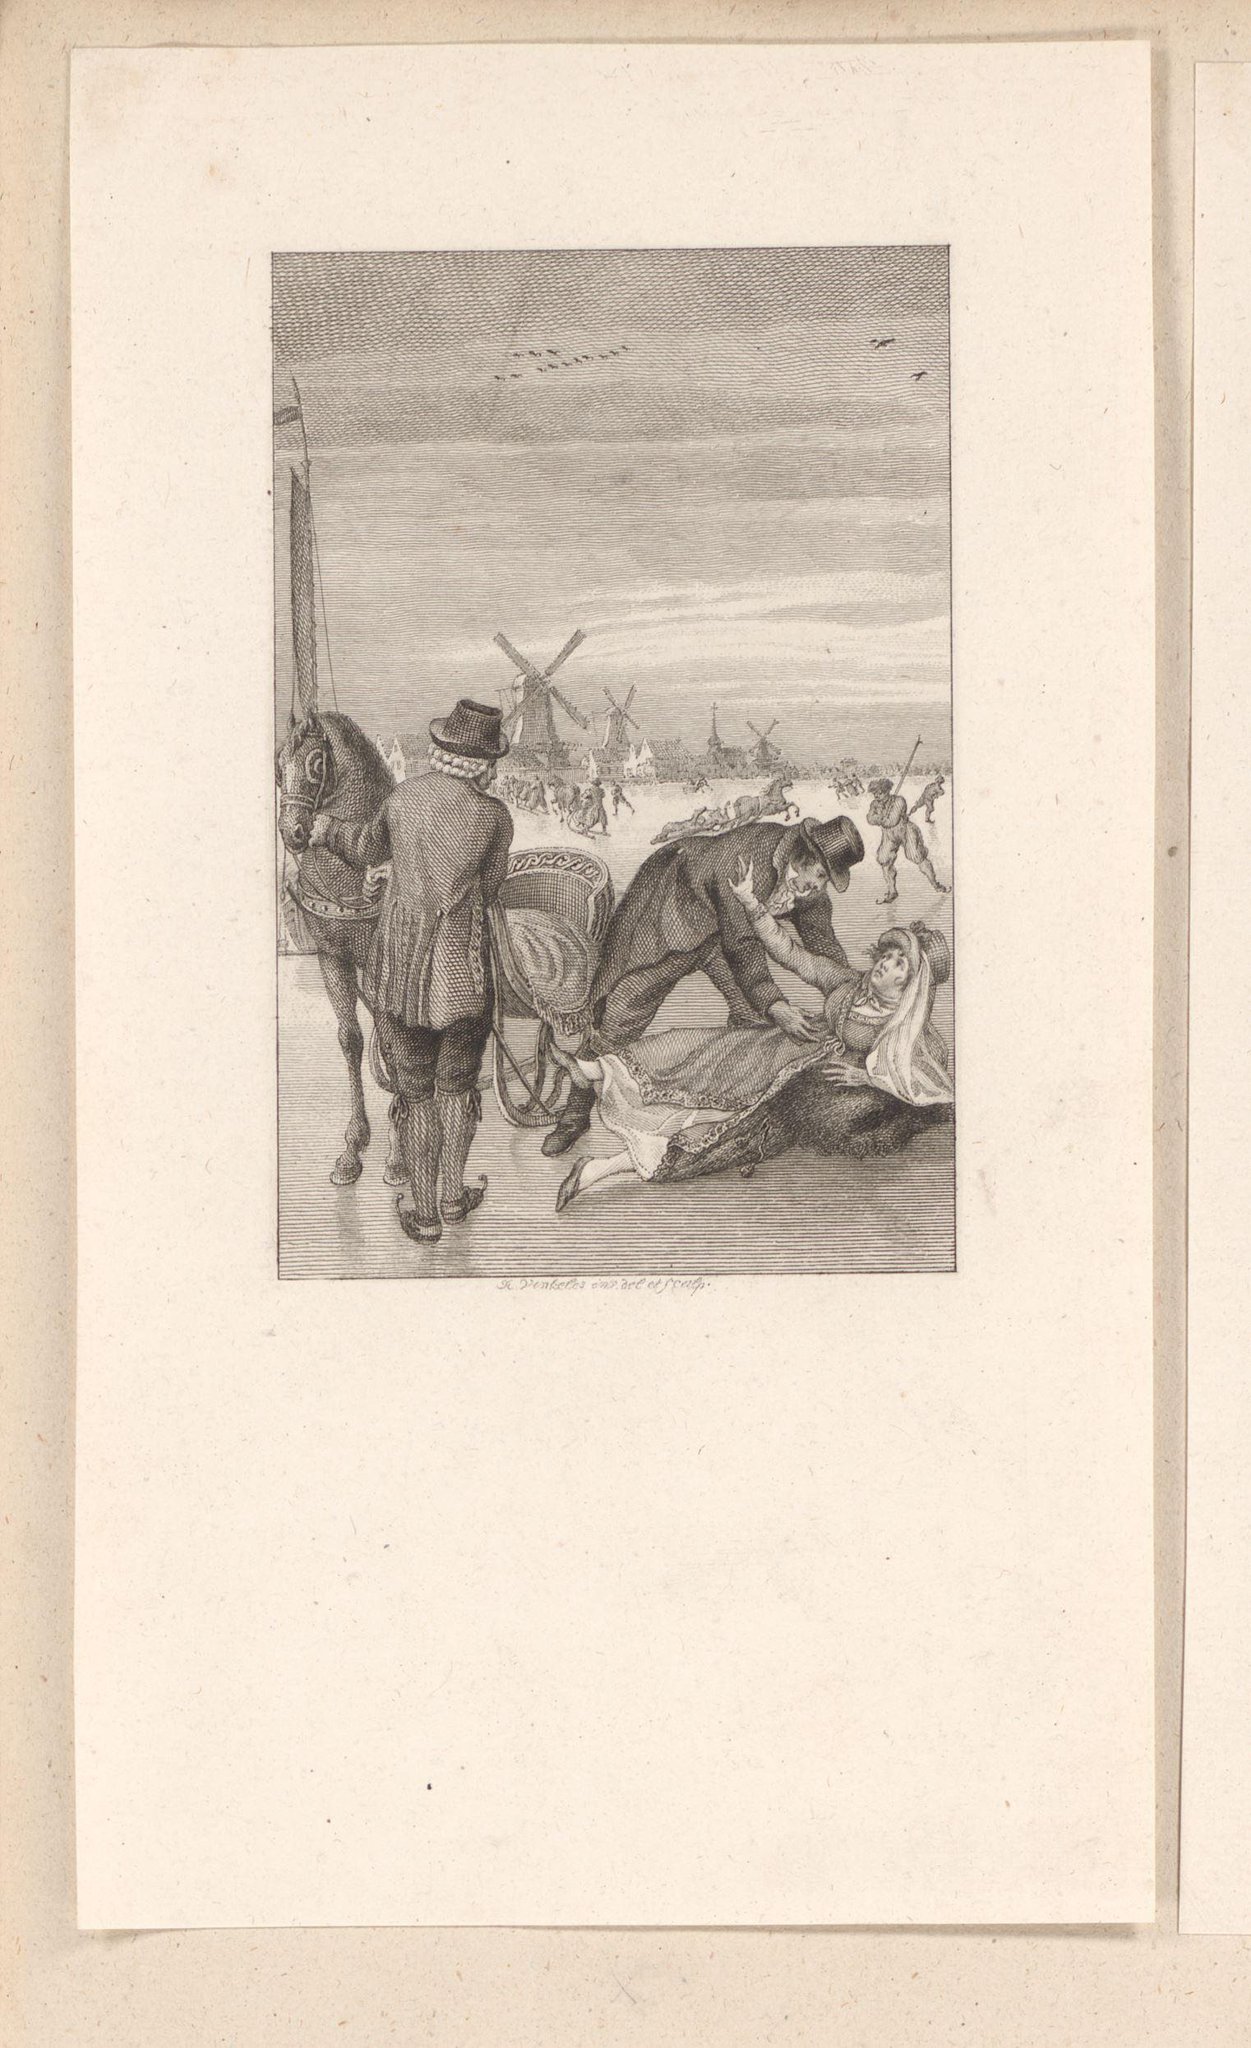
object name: book illustration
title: Susanna Bronkhorst glijdt uit op het ijs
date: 1806-1807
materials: paper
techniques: engraving, etching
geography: amsterdam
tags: slipping, skates (winter sports), ice ~ state of water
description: Proefdruk van een boekillustratie gebruikt in: Loosjes, Adriaan Pietersz. Historie van mejuffrouw Susanna Bronkhorst. Haarlem: Adriaan Loosjes, 1806-1807.